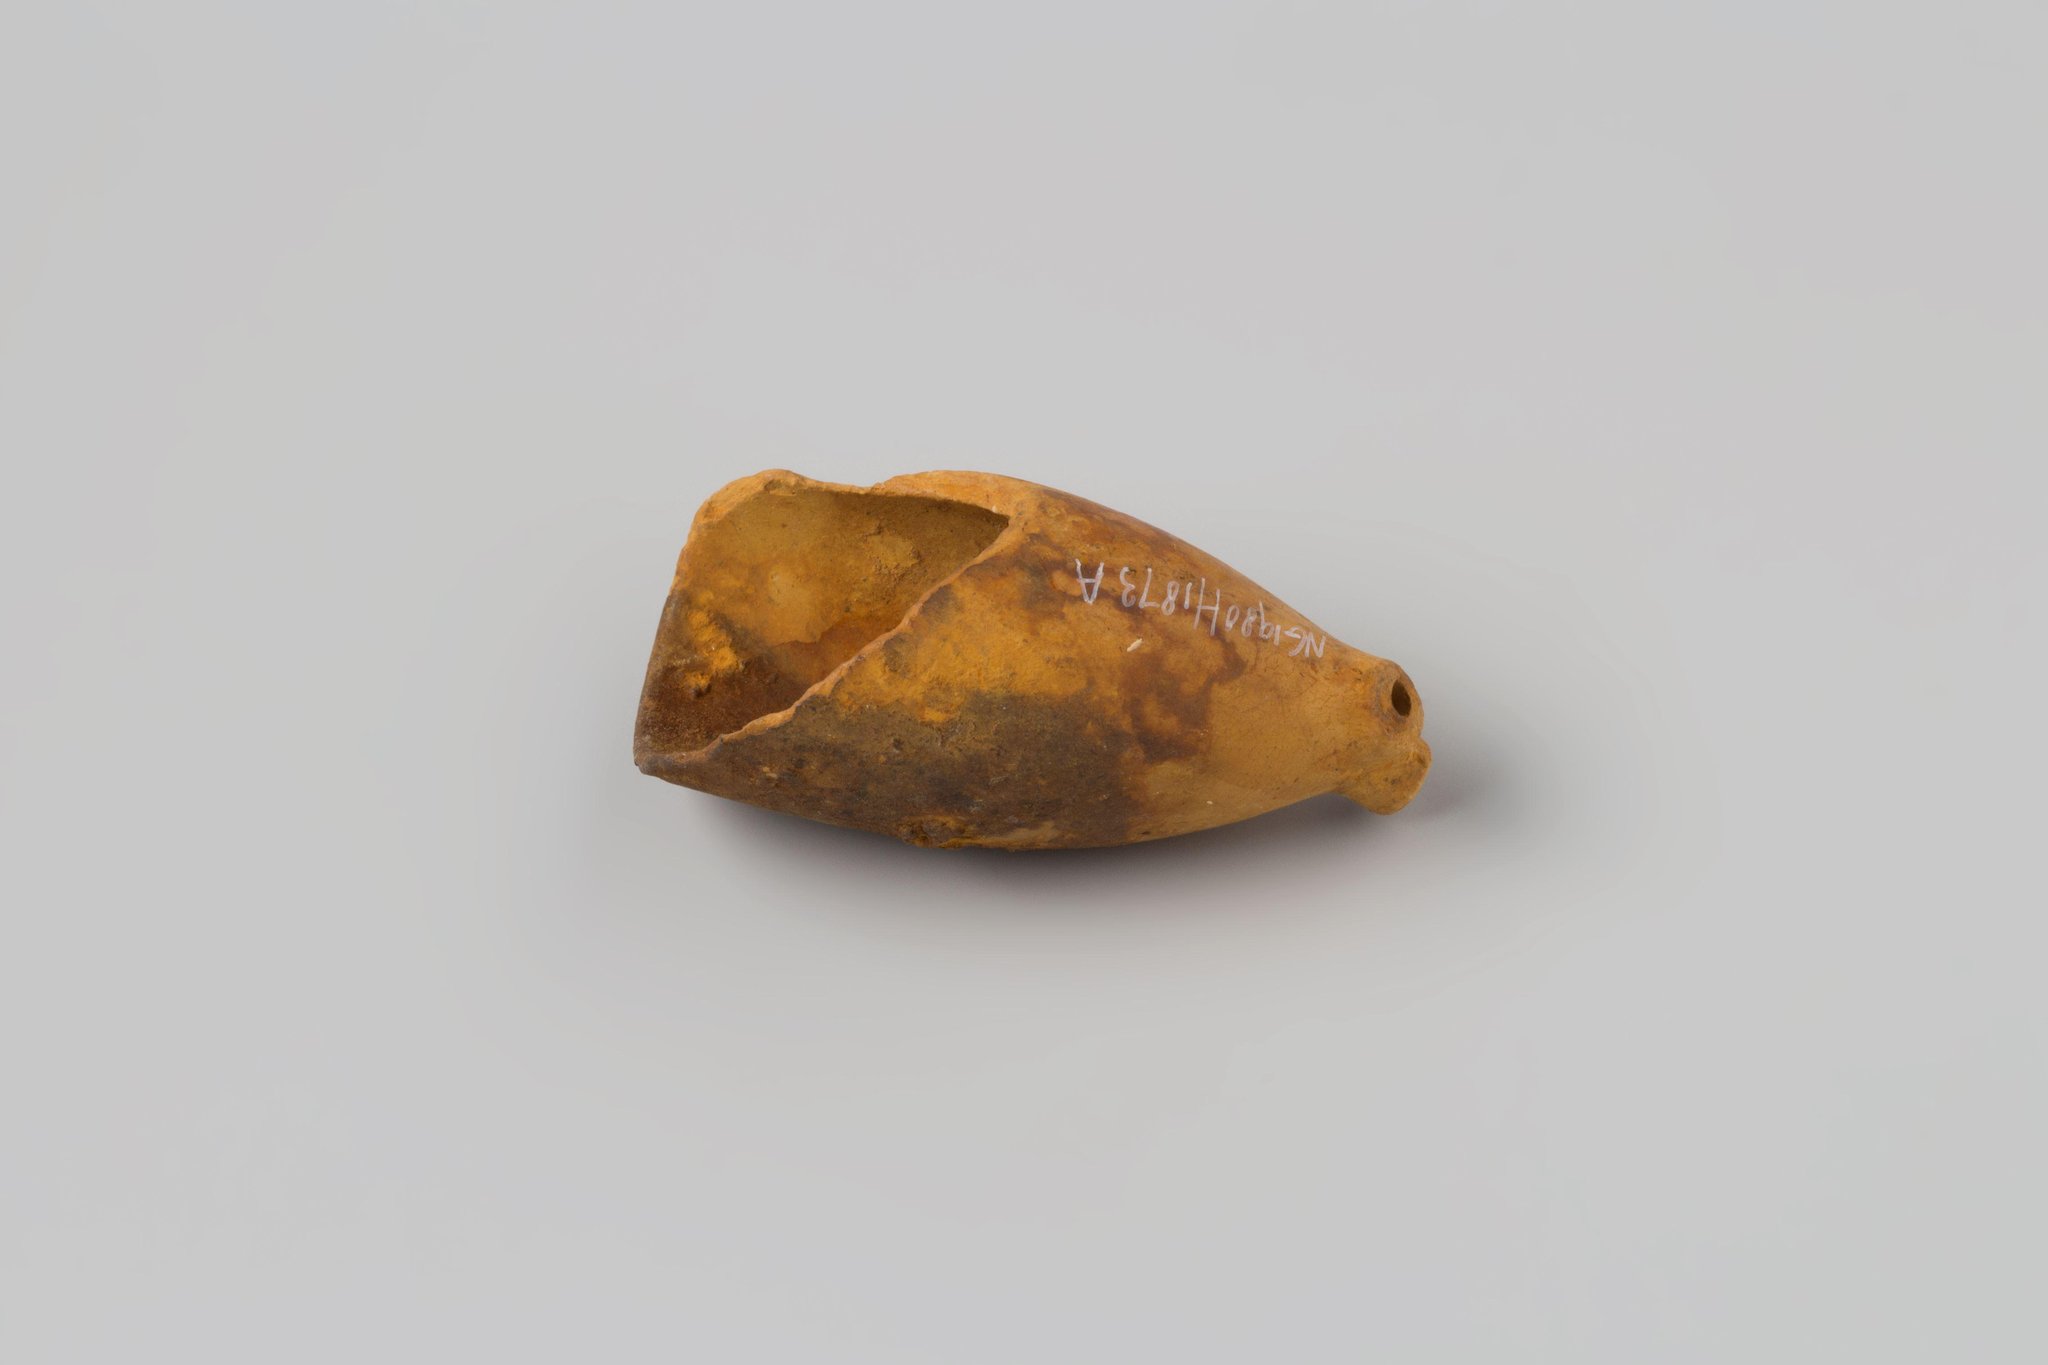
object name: pipe bowl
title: Fragment pijpenkop uit het wrak van de Oost-Indiëvaarder Hollandia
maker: Anonymous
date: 1700-1743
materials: clay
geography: netherlands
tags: verenigde oostindische compagnie, hollandia (schip), annet